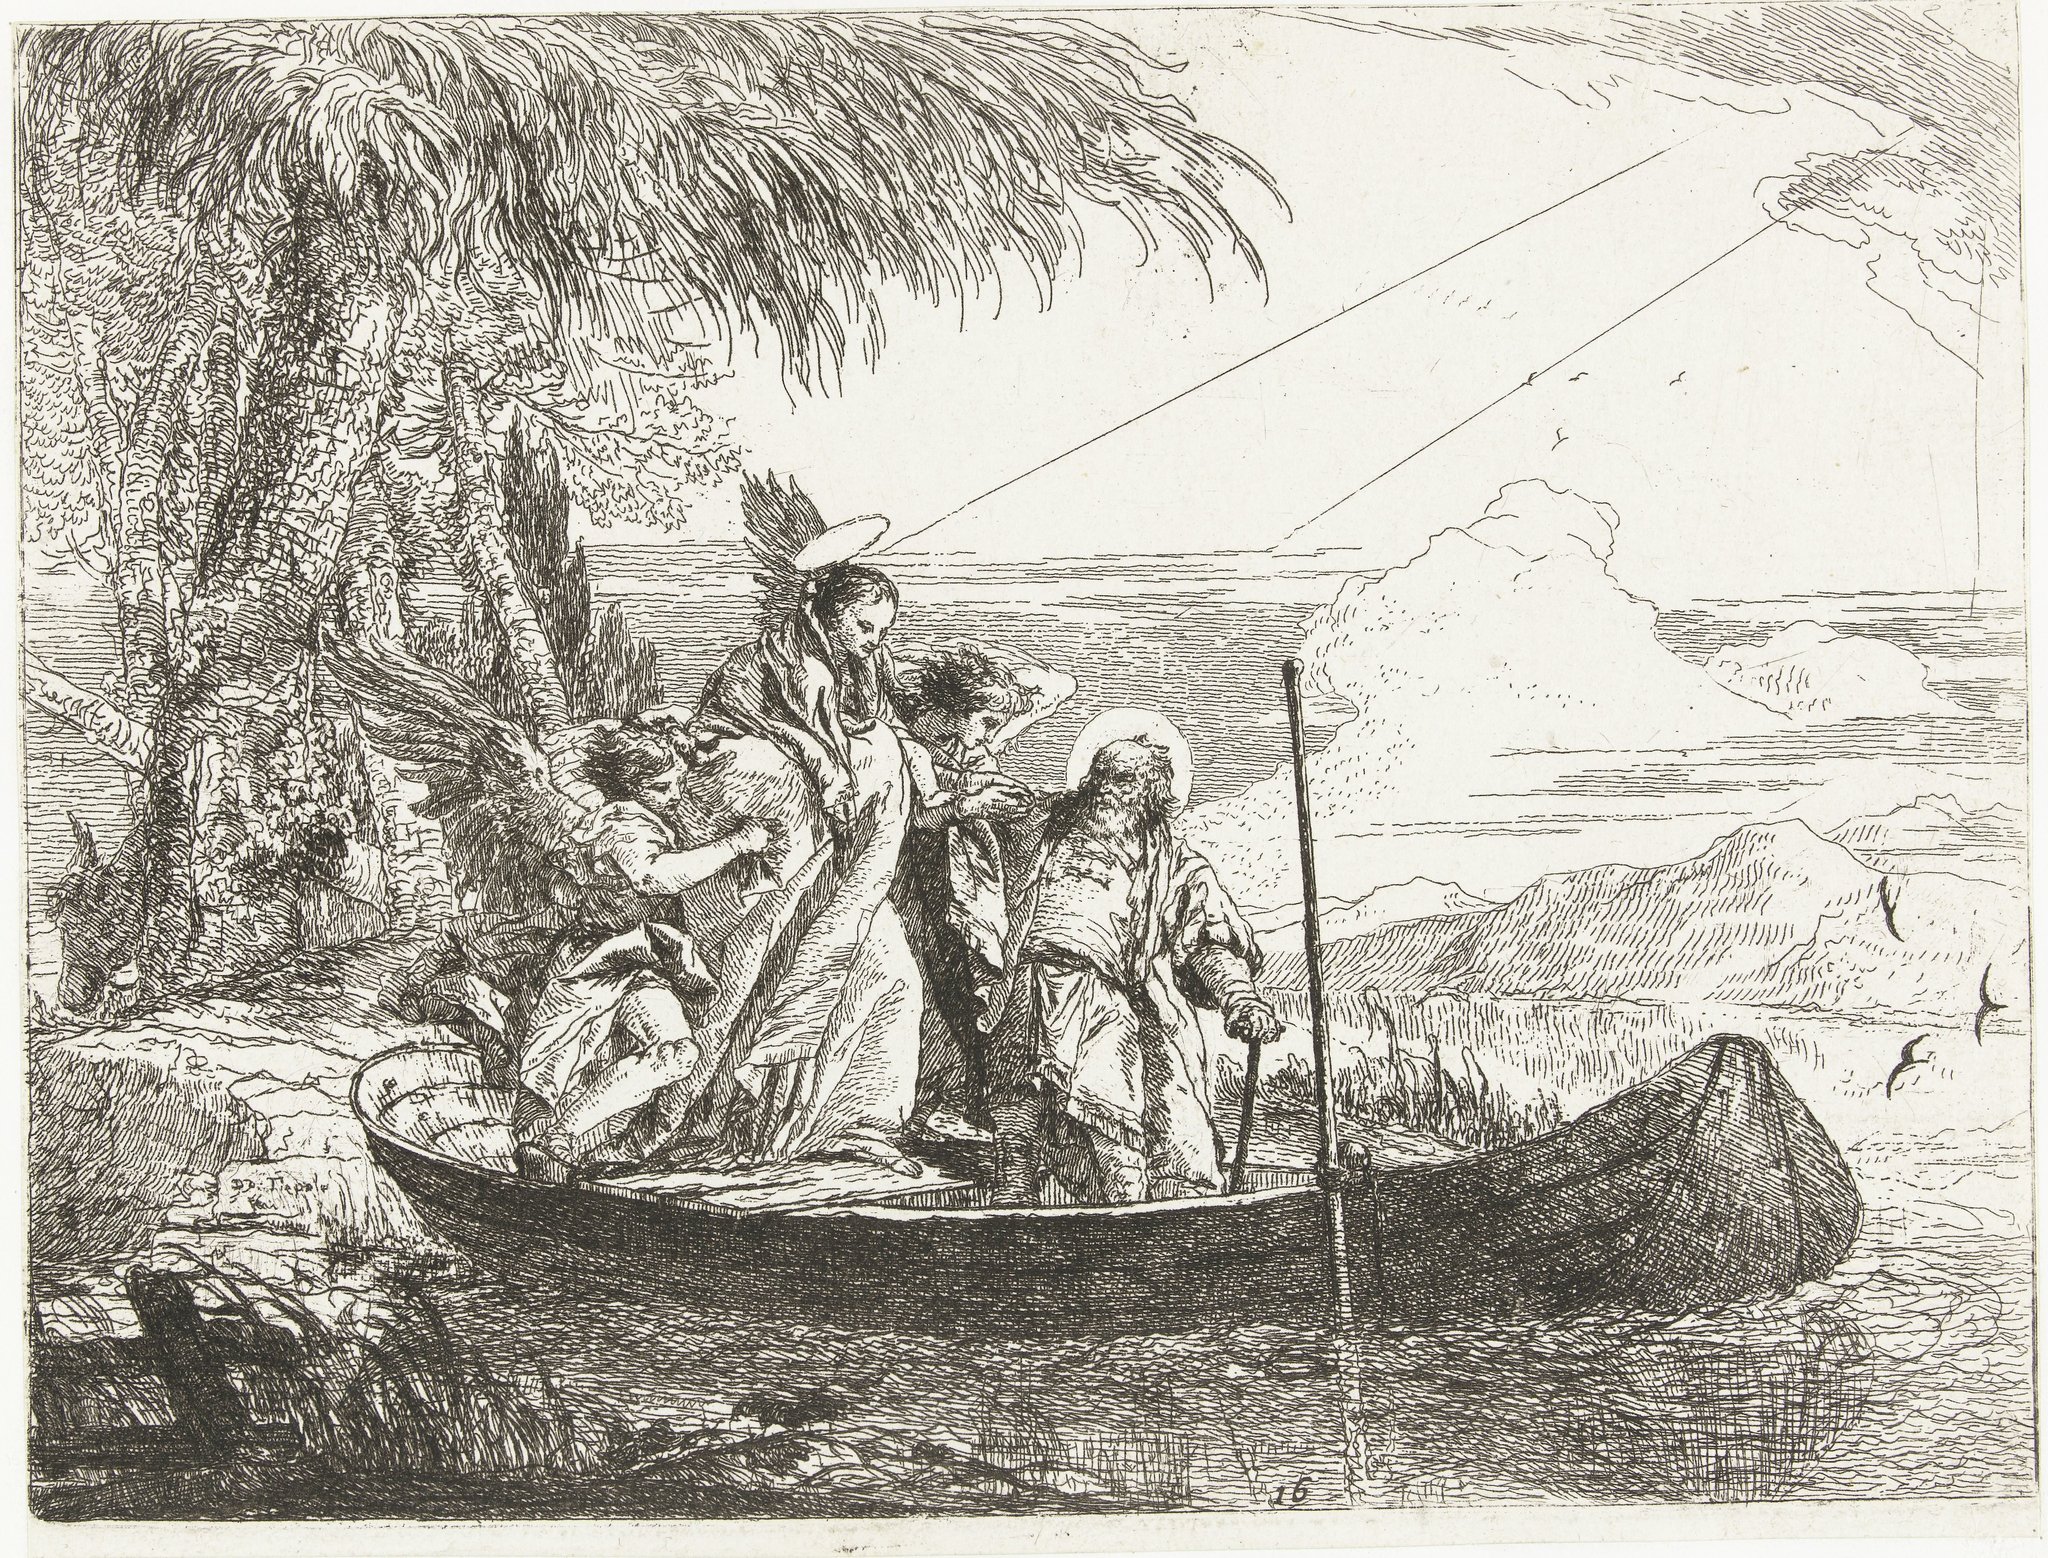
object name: print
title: Vlucht naar Egypte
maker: giovanni domenico tiepolo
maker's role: draughtsman, print maker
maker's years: 1727-1804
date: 1750-1753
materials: paper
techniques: etching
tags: flight into egypt and miracles during the journey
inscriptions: collector's mark: Lugt 2760, collector's mark: Lugt 2228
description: Prent uit serie van zevenentwintig prenten met de Vlucht naar Egypte.